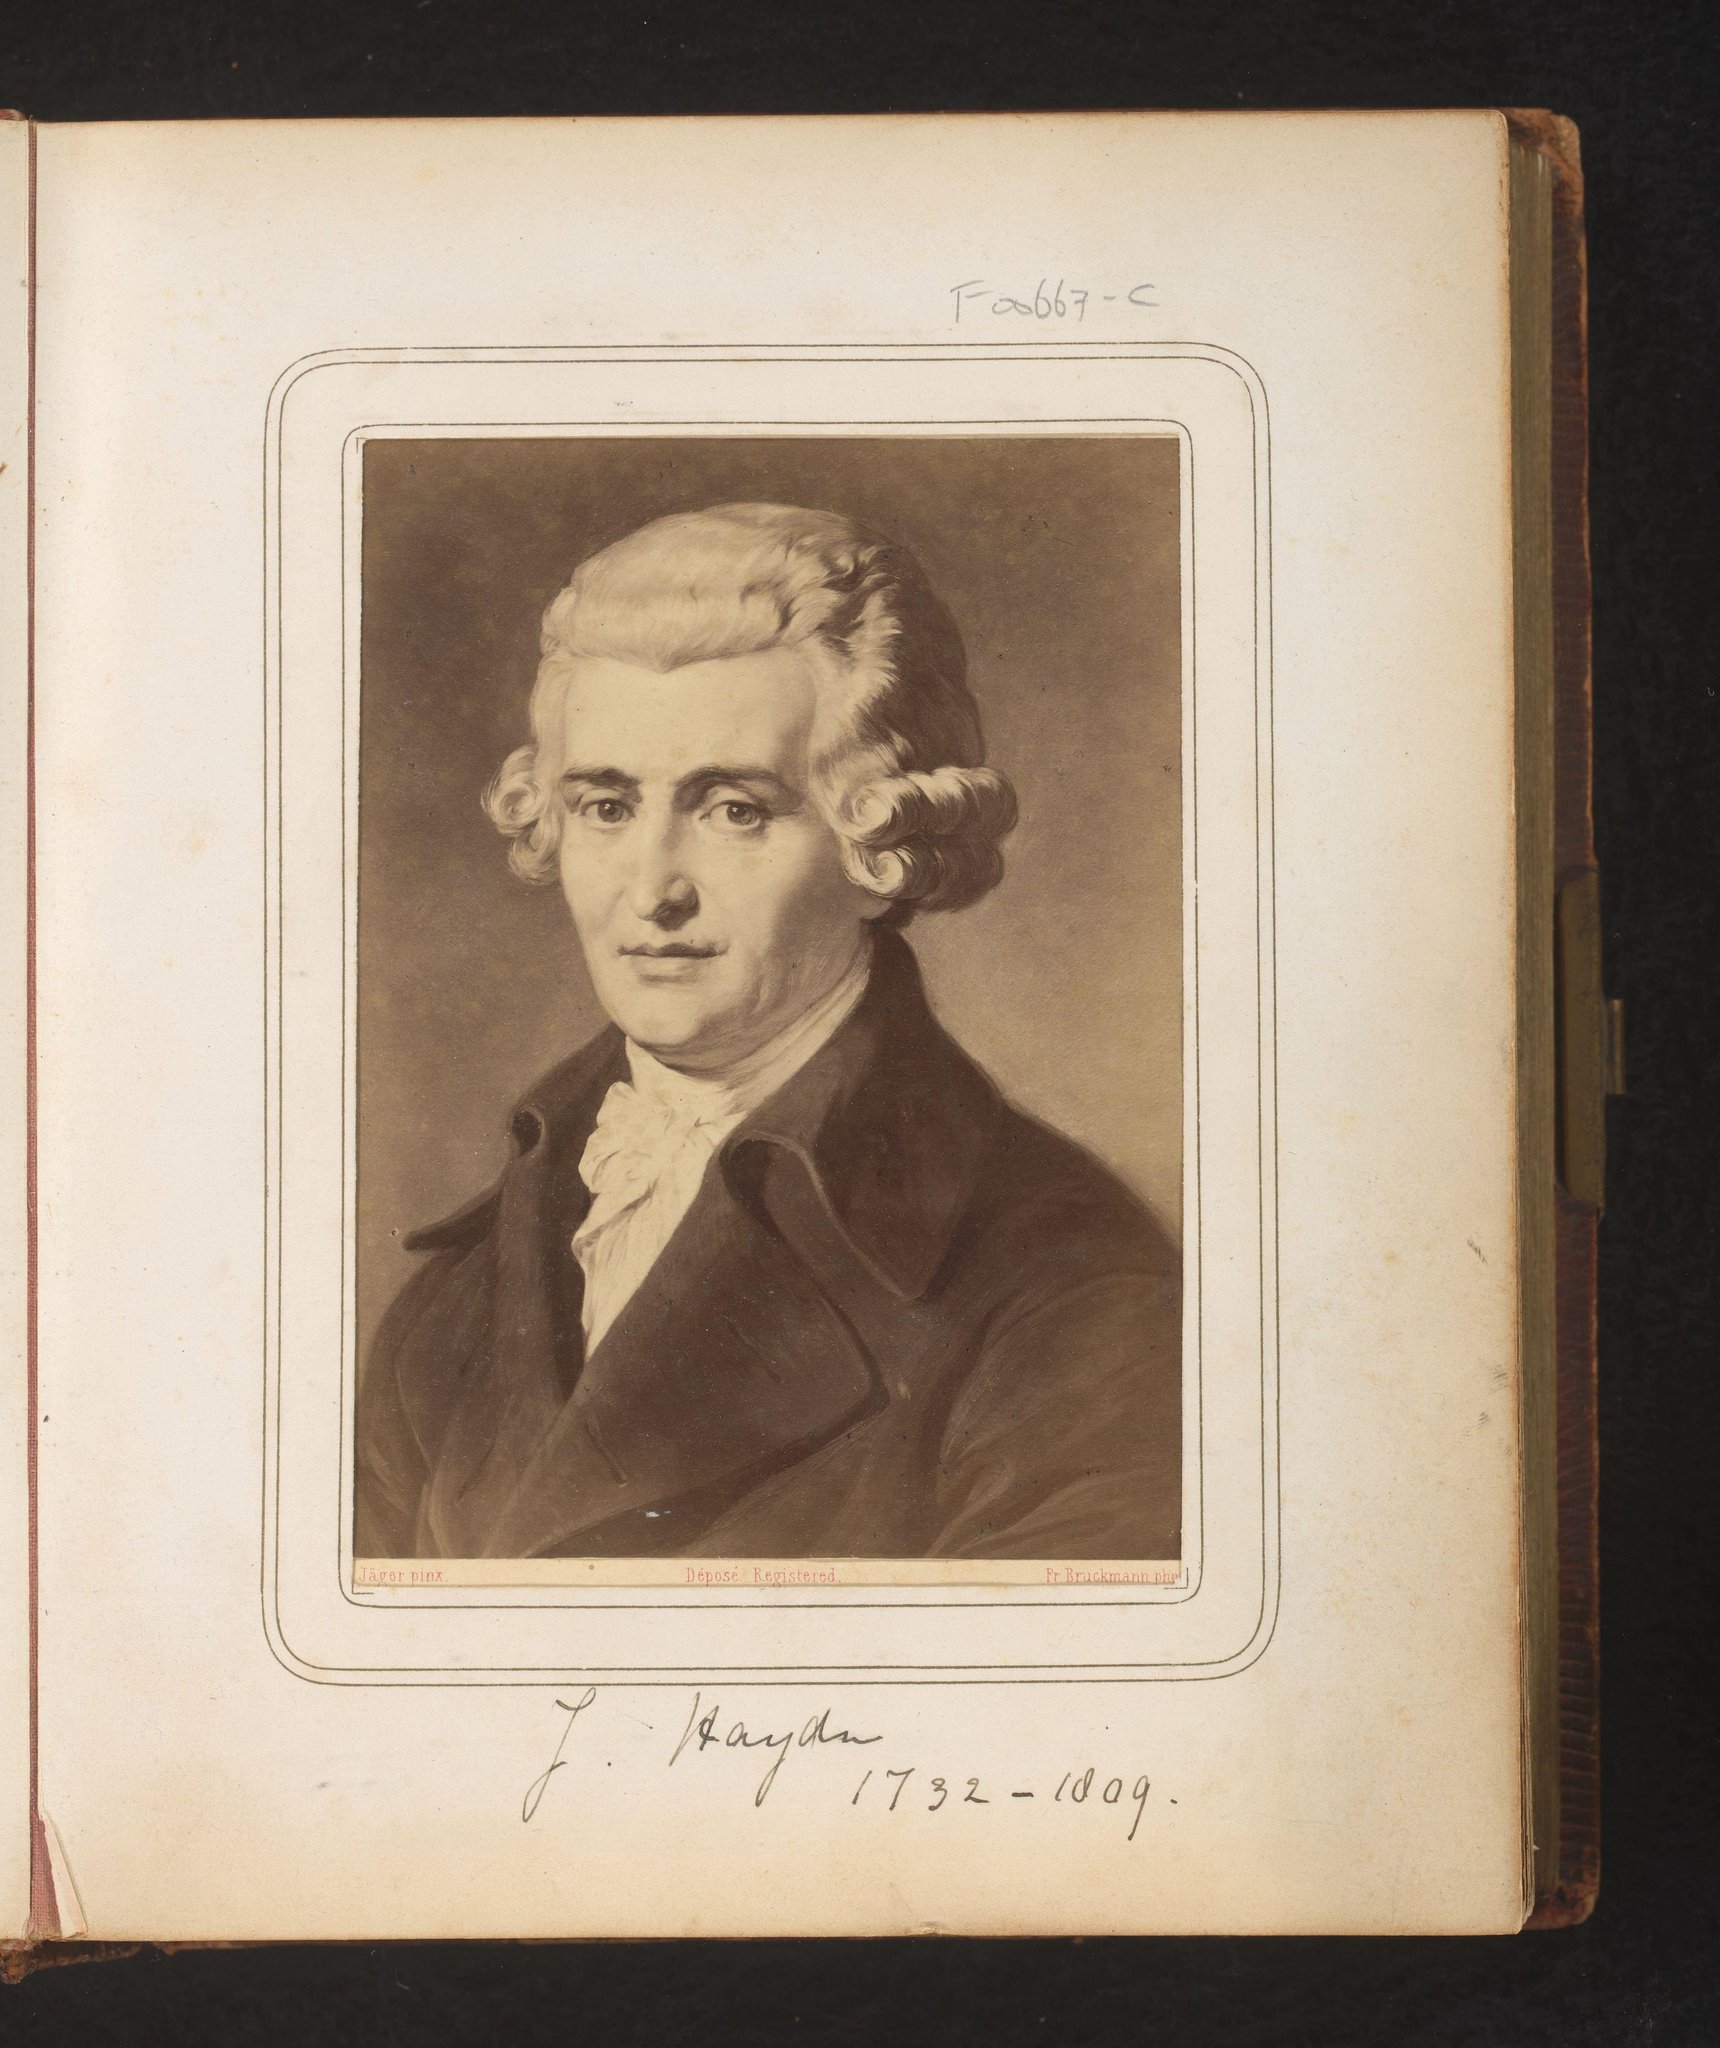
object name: cabinet photograph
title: Fotoreproductie van een geschilderd portret van Joseph Haydn door Carl Jaeger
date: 1870-1890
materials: cardboard, photographic support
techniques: albumen print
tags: historical persons, portrait of composer, picture, painting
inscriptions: annotation: ‘J. Haydn/ 1735 - 1809’, name: ‘Jäger pinx. Déposé Registered/ Fr. Bruckmann pho[...]’